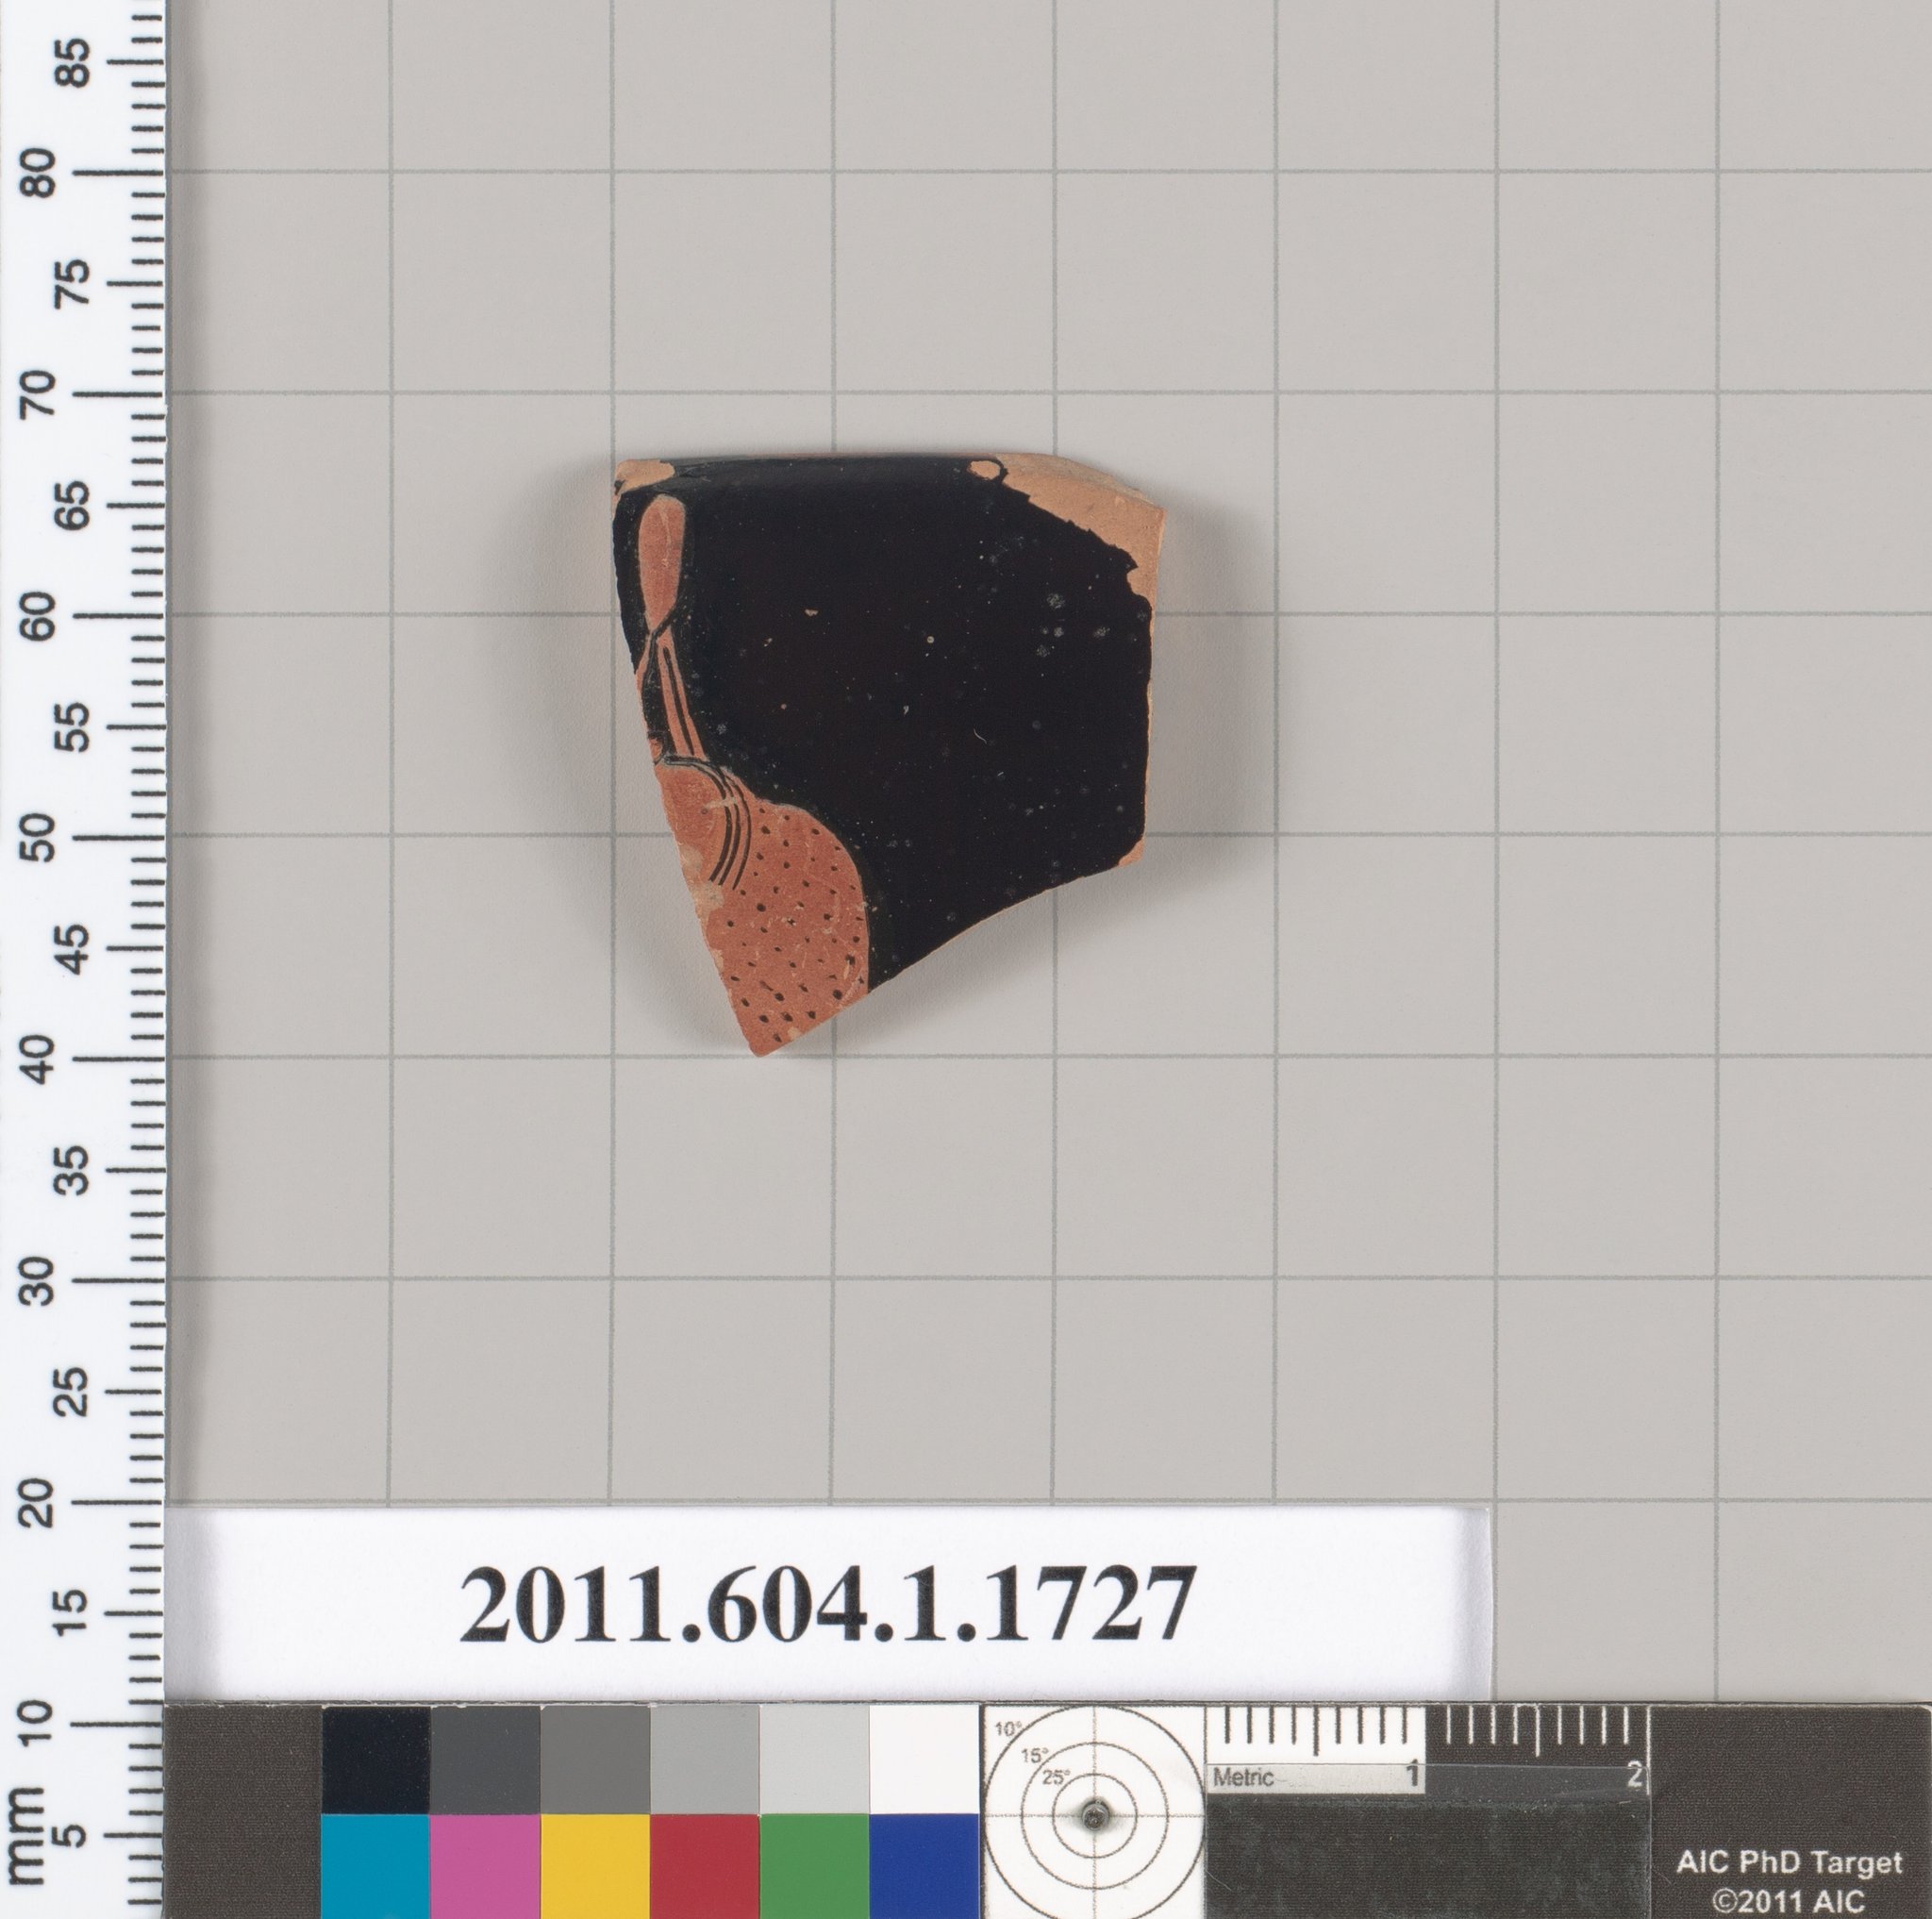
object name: kylix fragment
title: Terracotta rim fragment of a kylix (drinking cup)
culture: greek, attic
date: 490-480 BCE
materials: terracotta